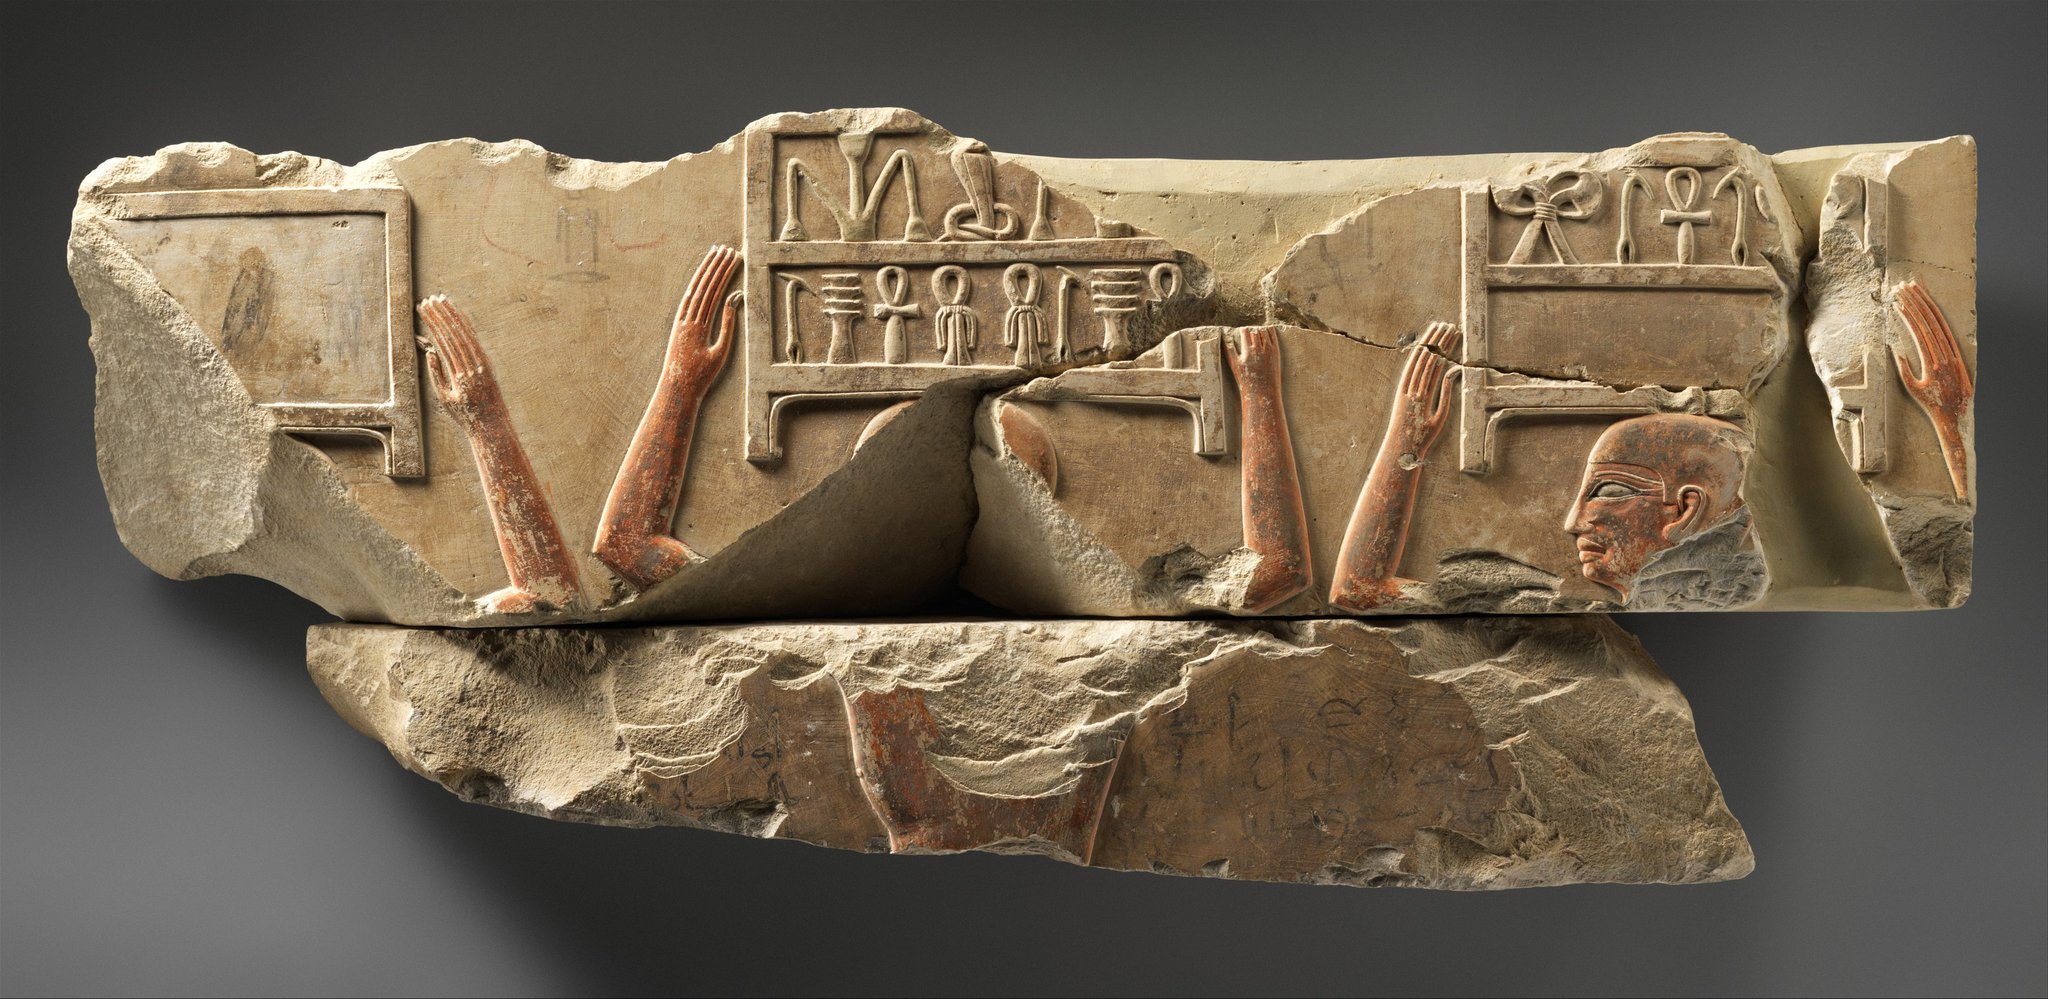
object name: relief, men carrying chest, neferu, linen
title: Relief of offering bearers carrying boxes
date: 2051-2030 BCE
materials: limestone, paint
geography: egypt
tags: hands,heads